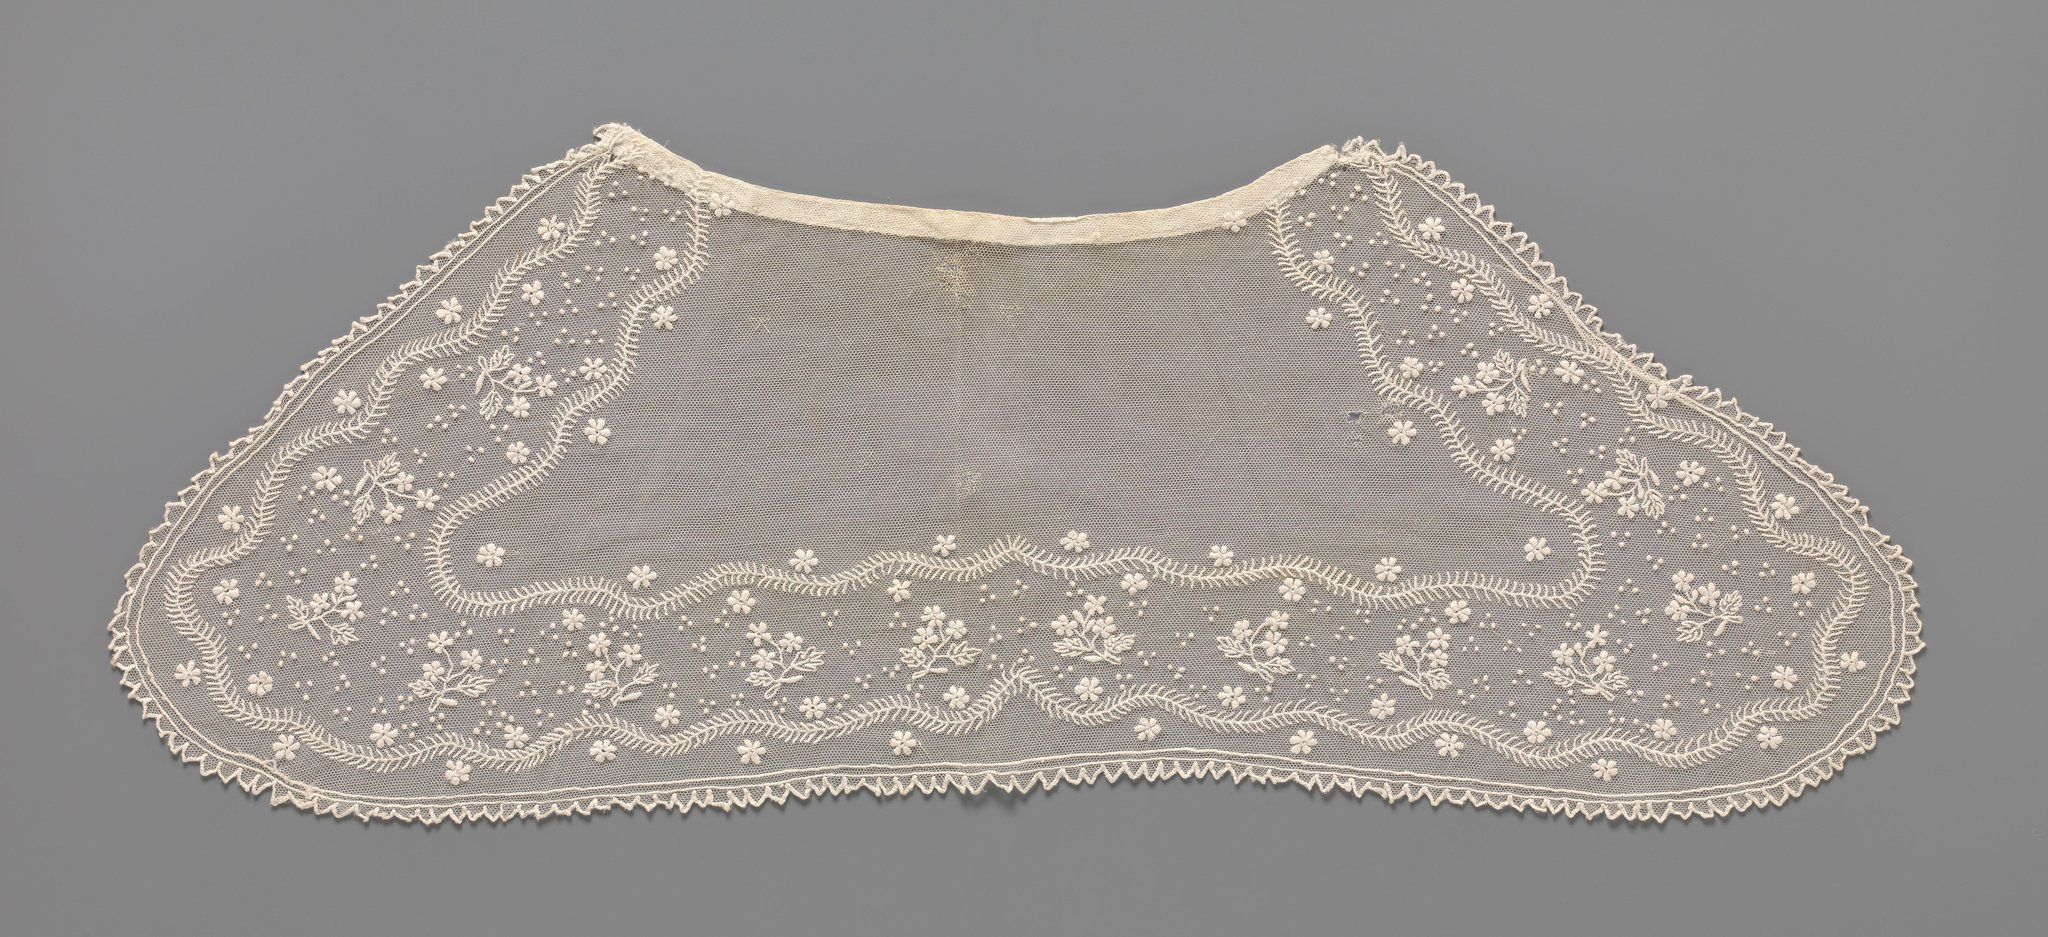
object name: pelerine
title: Pelerine-kraag, alleen de bovenste laag, van kantborduurwerk op machinale tule met bloemtakjes tussen golvende geverderde lijnen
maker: Anonymous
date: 1835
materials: linen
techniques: embroidered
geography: europe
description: Kraag van een pelerine van naturelkleurig kantborduurwerk op machinale tule: tuledoorstopwerk. Het betreft alleen de bovenste laag van een pelerine. Trapeziumvormig model met sterk afgeronde hoeken. Rond een leeg middenveld loopt een brede geborduurde lijst van twee doorlopende en licht golvende gevederde lijnen. In elk golfdal en onder elke golftop staat een rozetbloempje. Tussen de gevederde lijnen staan bloemtakjes met vergelijkbare rozetbloempjes tussen een strooipatroon van moesjes in groepjes van drie. Langs de schuine zijden en doorlopend langs de onderzijde loopt een schulpenrand van driehoekige schulpjes. Langs de bovenzijde is een geweven lint genaaid.